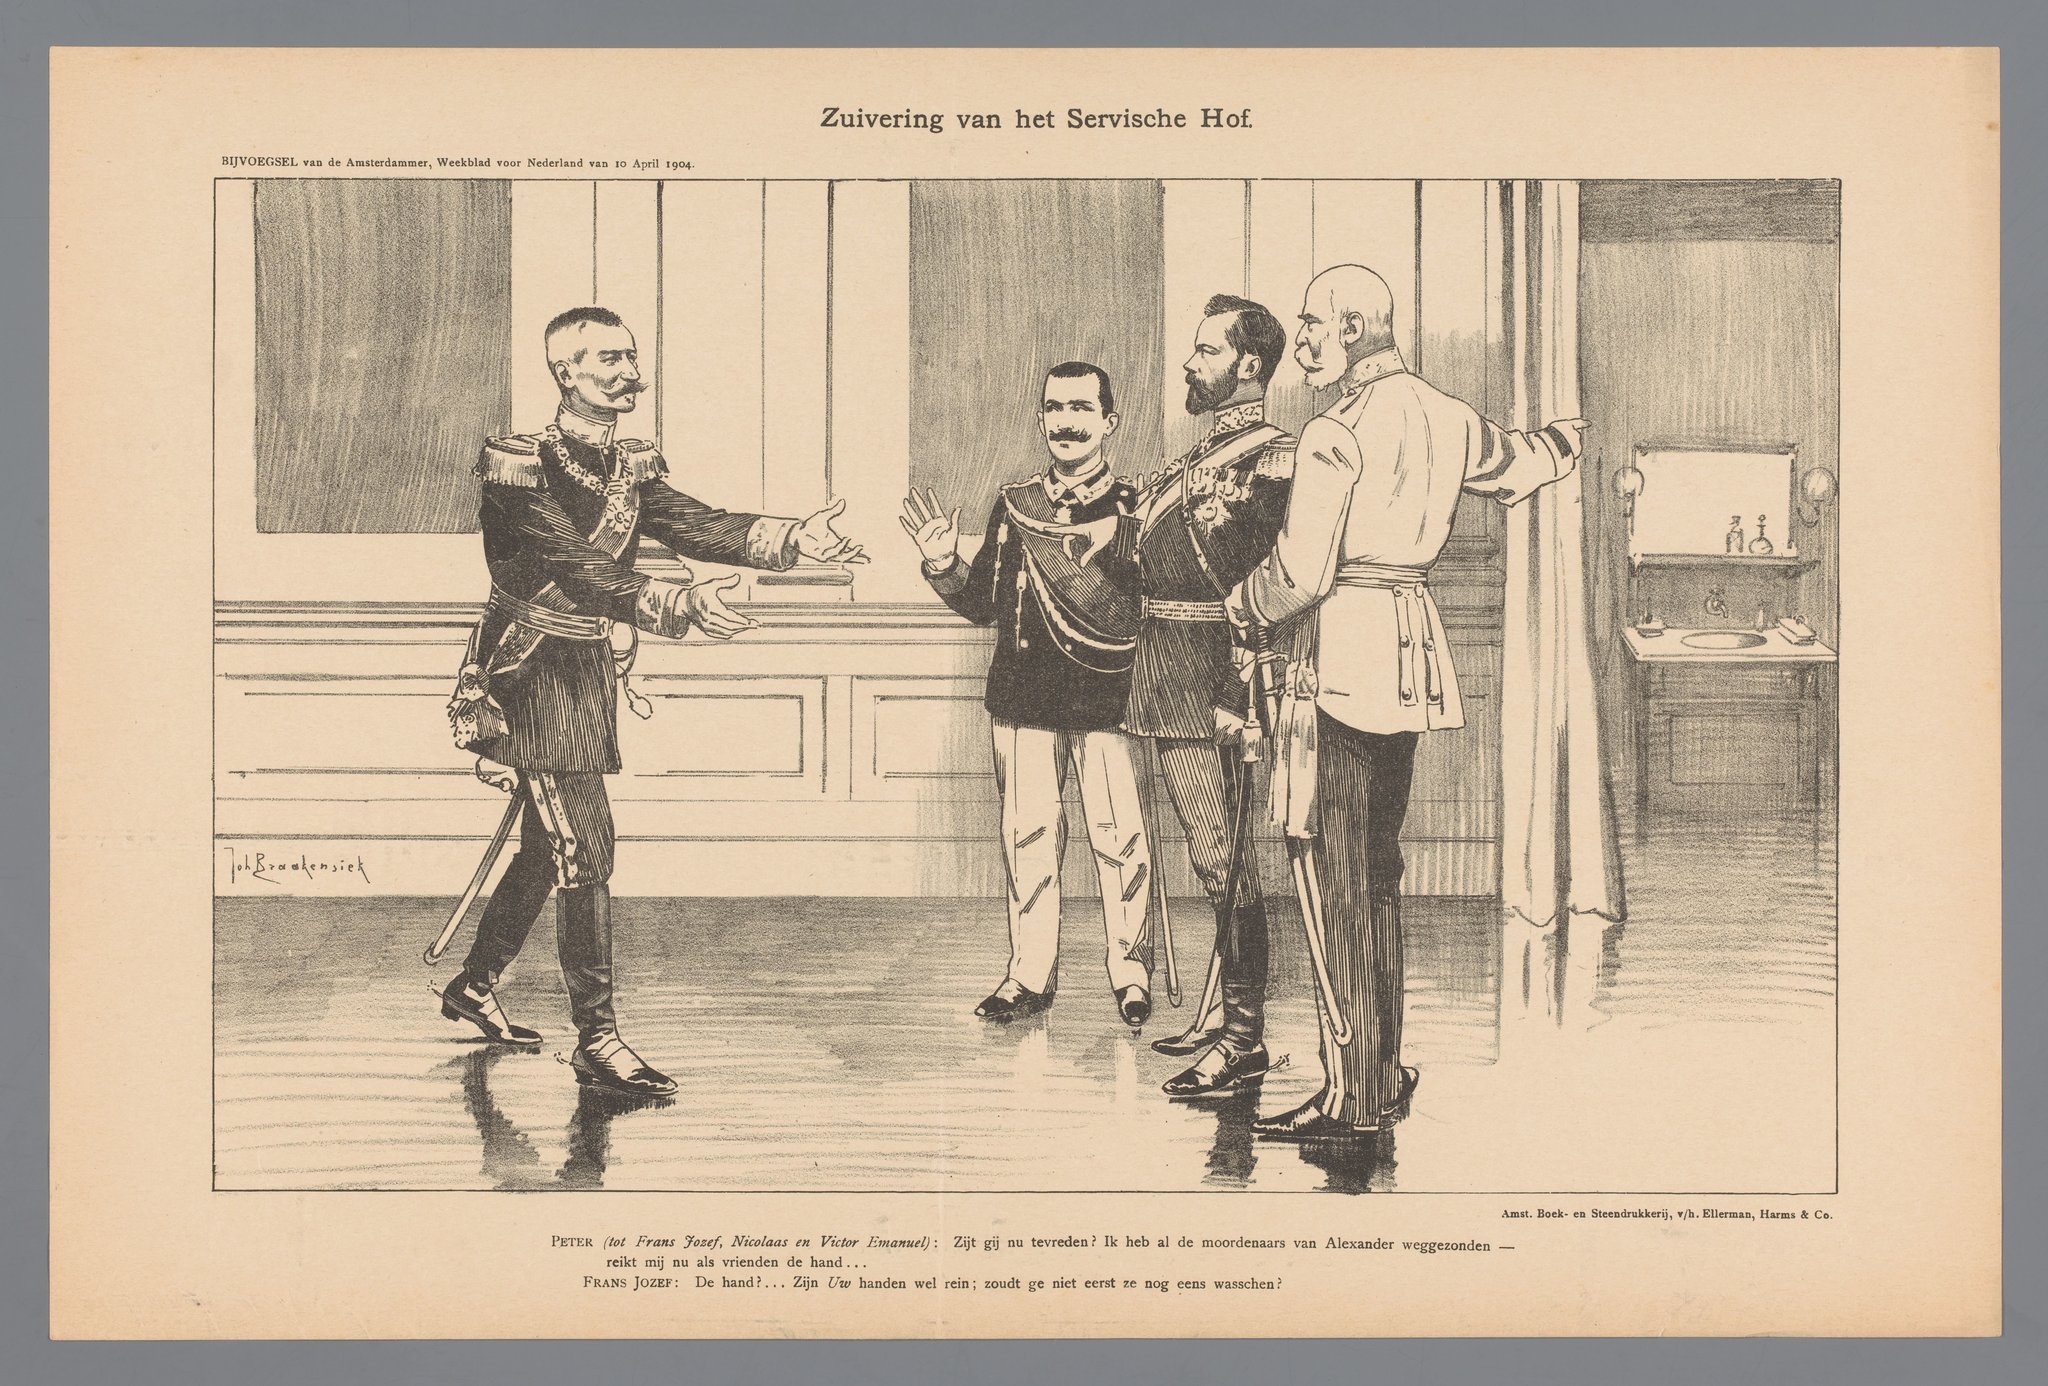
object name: cartoon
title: Zuivering van het Servische Hof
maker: johan braakensiek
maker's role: draughtsman, print maker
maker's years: 1858-1940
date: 1904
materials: paper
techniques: lithograph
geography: amsterdam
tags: vienna, historical persons, ruler, sovereign, political caricatures and satires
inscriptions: date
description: Prent uit het bijvoegsel van: De Amsterdammer. Weekblad voor Nederland, 10 april 1904.